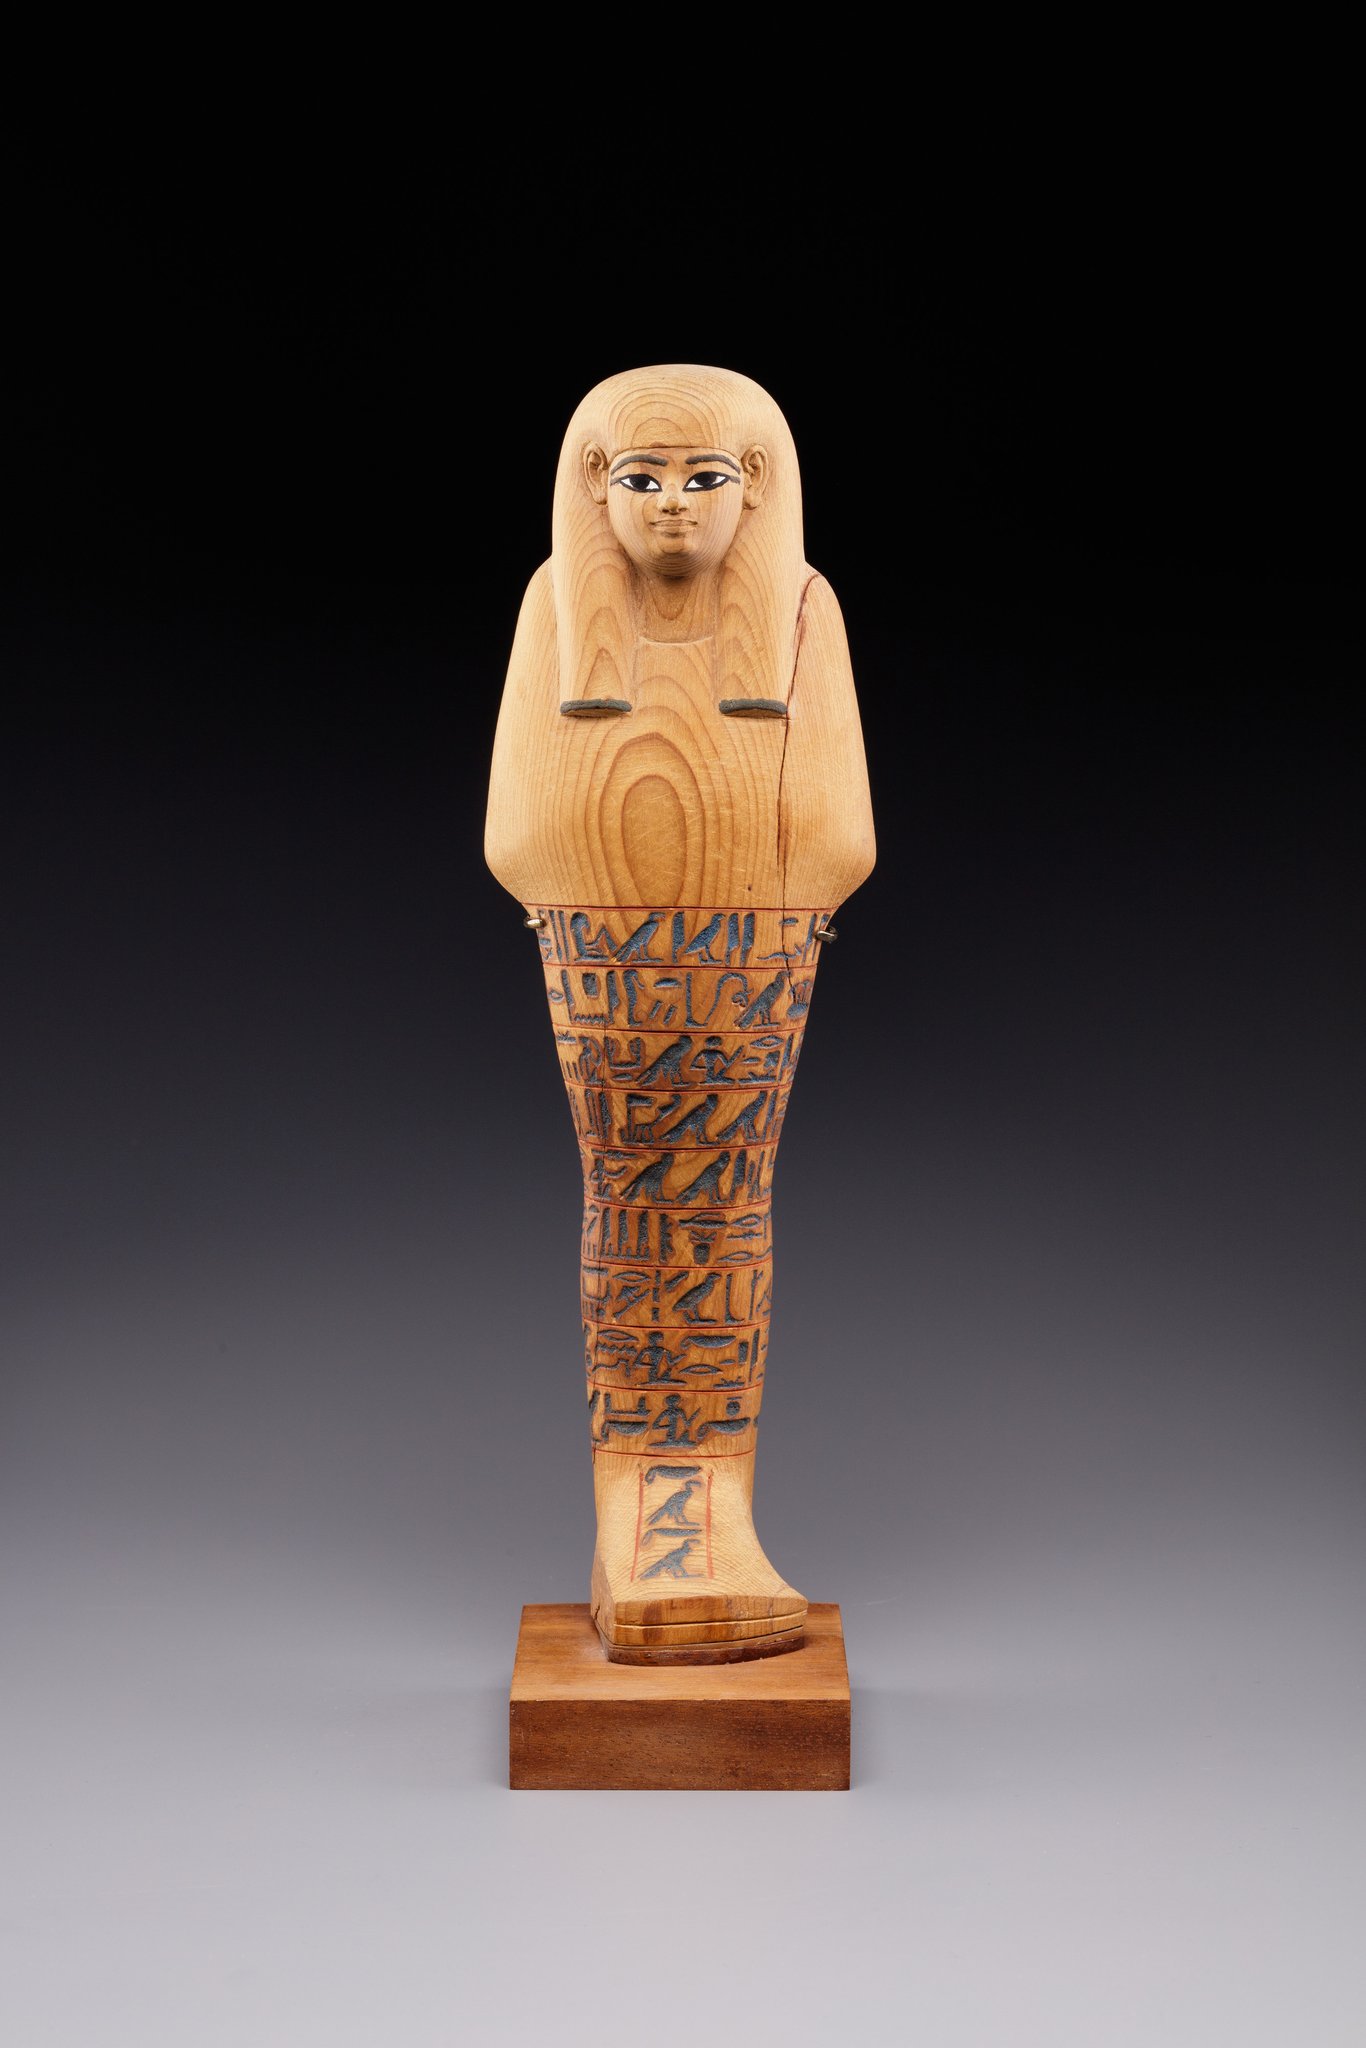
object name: shabti, yuya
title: Shabti of Yuya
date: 1390-1352 BCE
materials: wood, ink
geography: egypt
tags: hieroglyphs